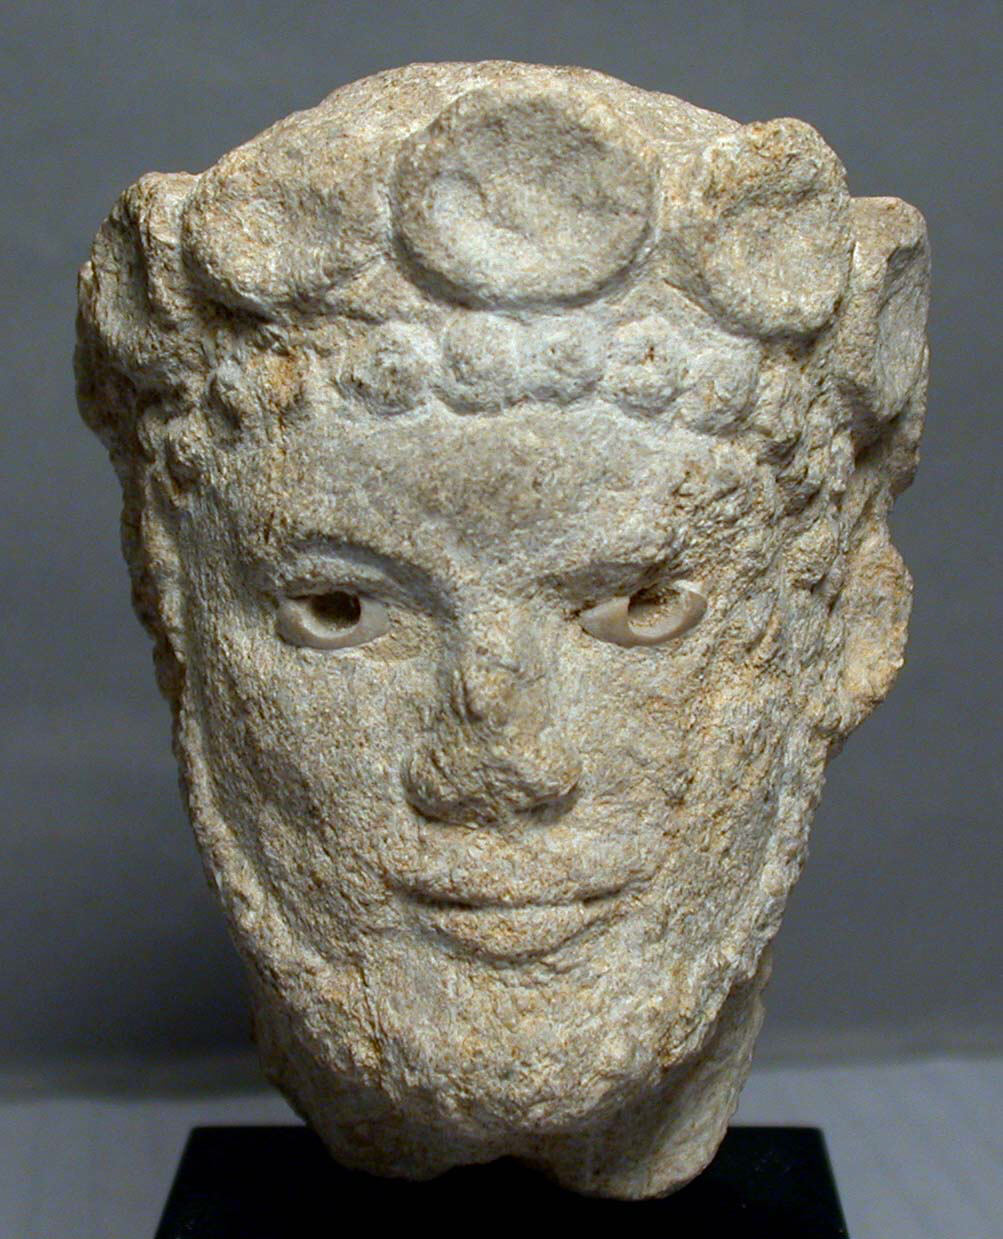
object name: head of a man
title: Limestone head of a bearded man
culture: cypriot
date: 400-301 BCE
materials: limestone